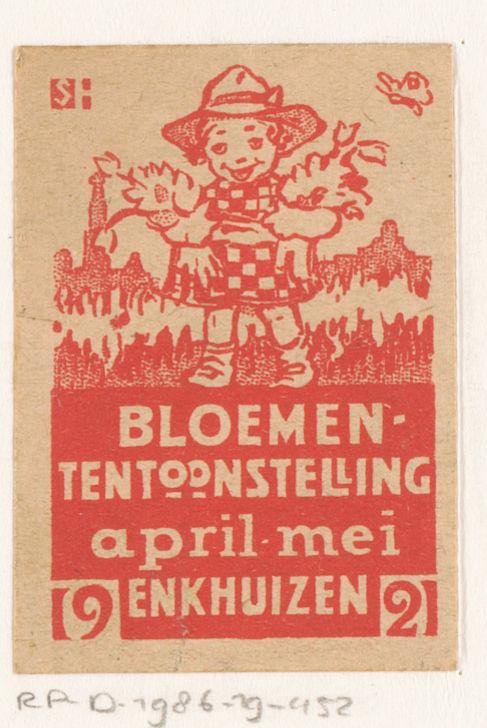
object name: print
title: Vignet voor de bloemententoonstelling te Enkhuizen in 1921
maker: Anonymous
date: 1921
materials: paper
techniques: printing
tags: cut flowers; nosegay, bunch of flowers, toddler - aa - girl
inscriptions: collector's mark: ‘R:MVS.’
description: Lachend meisje met bloemen in haar armen.